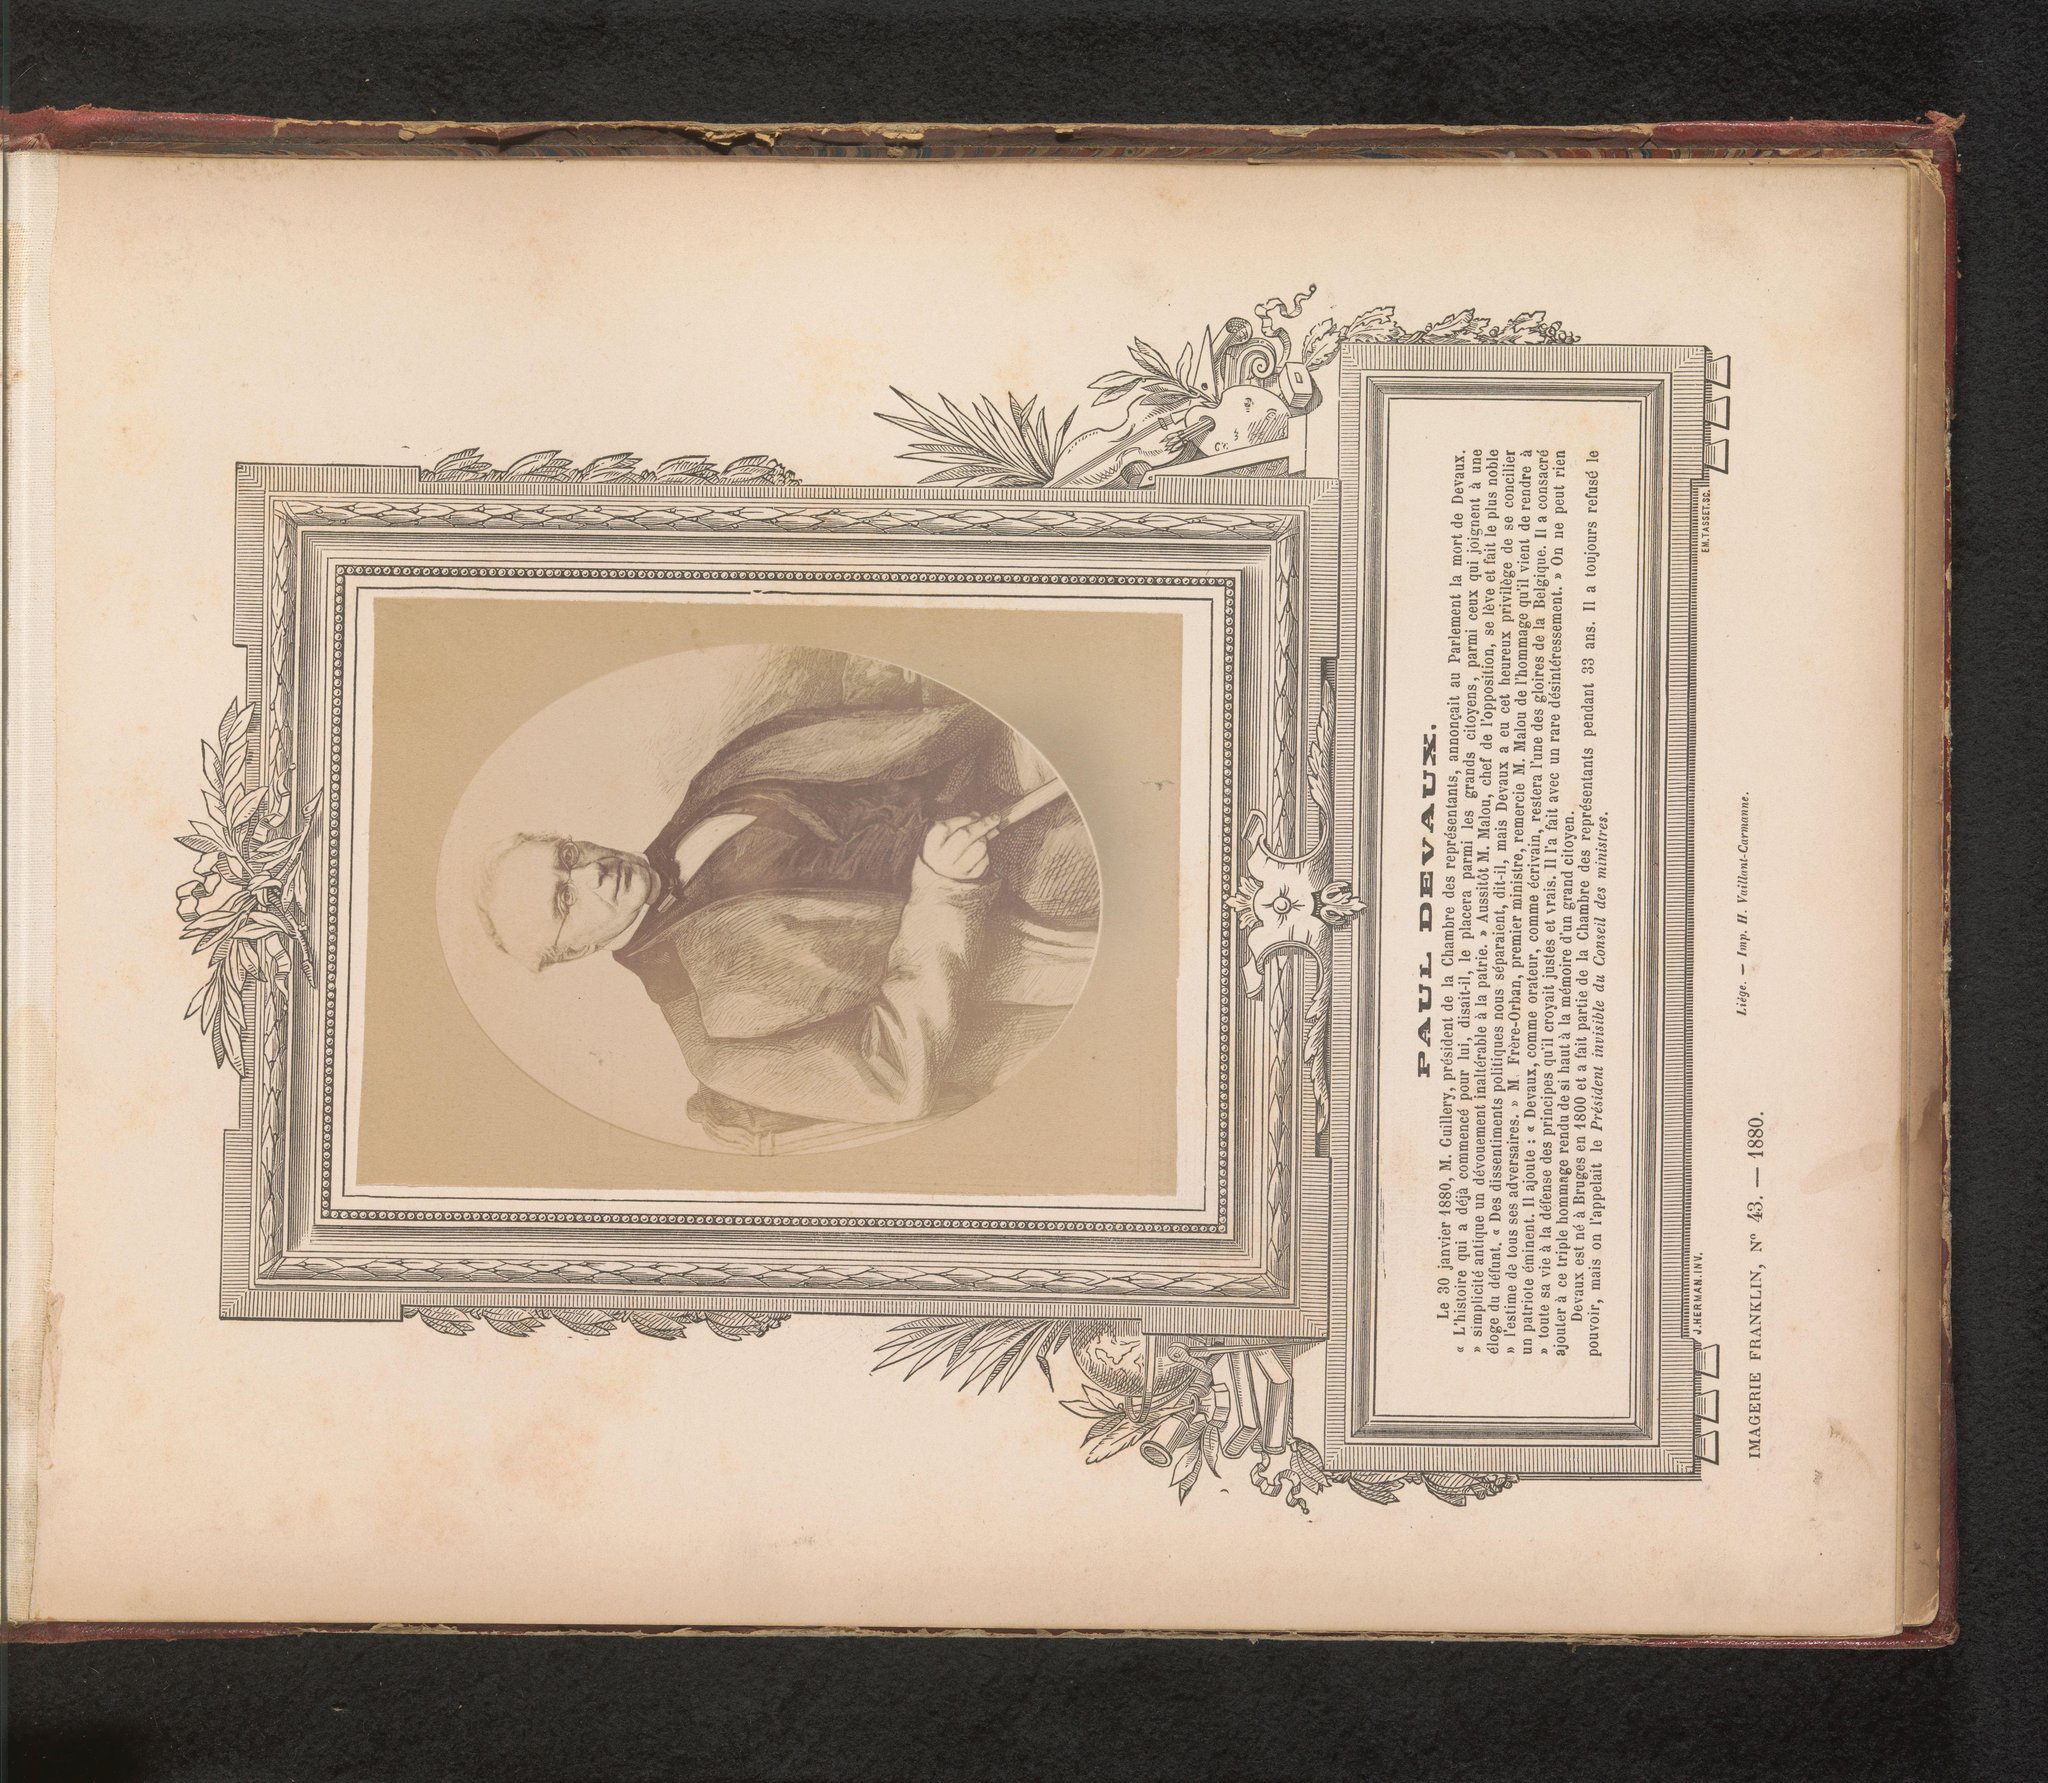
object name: page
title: Fotoreproductie van een prent van een portret van Paul Devaux door Burn Smeeton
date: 1875-1880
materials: photographic support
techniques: albumen print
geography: liège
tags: bruges, politician, historical persons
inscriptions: name: ‘EM. TASSET, SC.’, inscription: ‘Le 30 janvier (...) des ministres.’, name: ‘J. HERMAN, INV.’, inscription: ‘IMAGERIE FRANKLIN No 43. - 1880.’